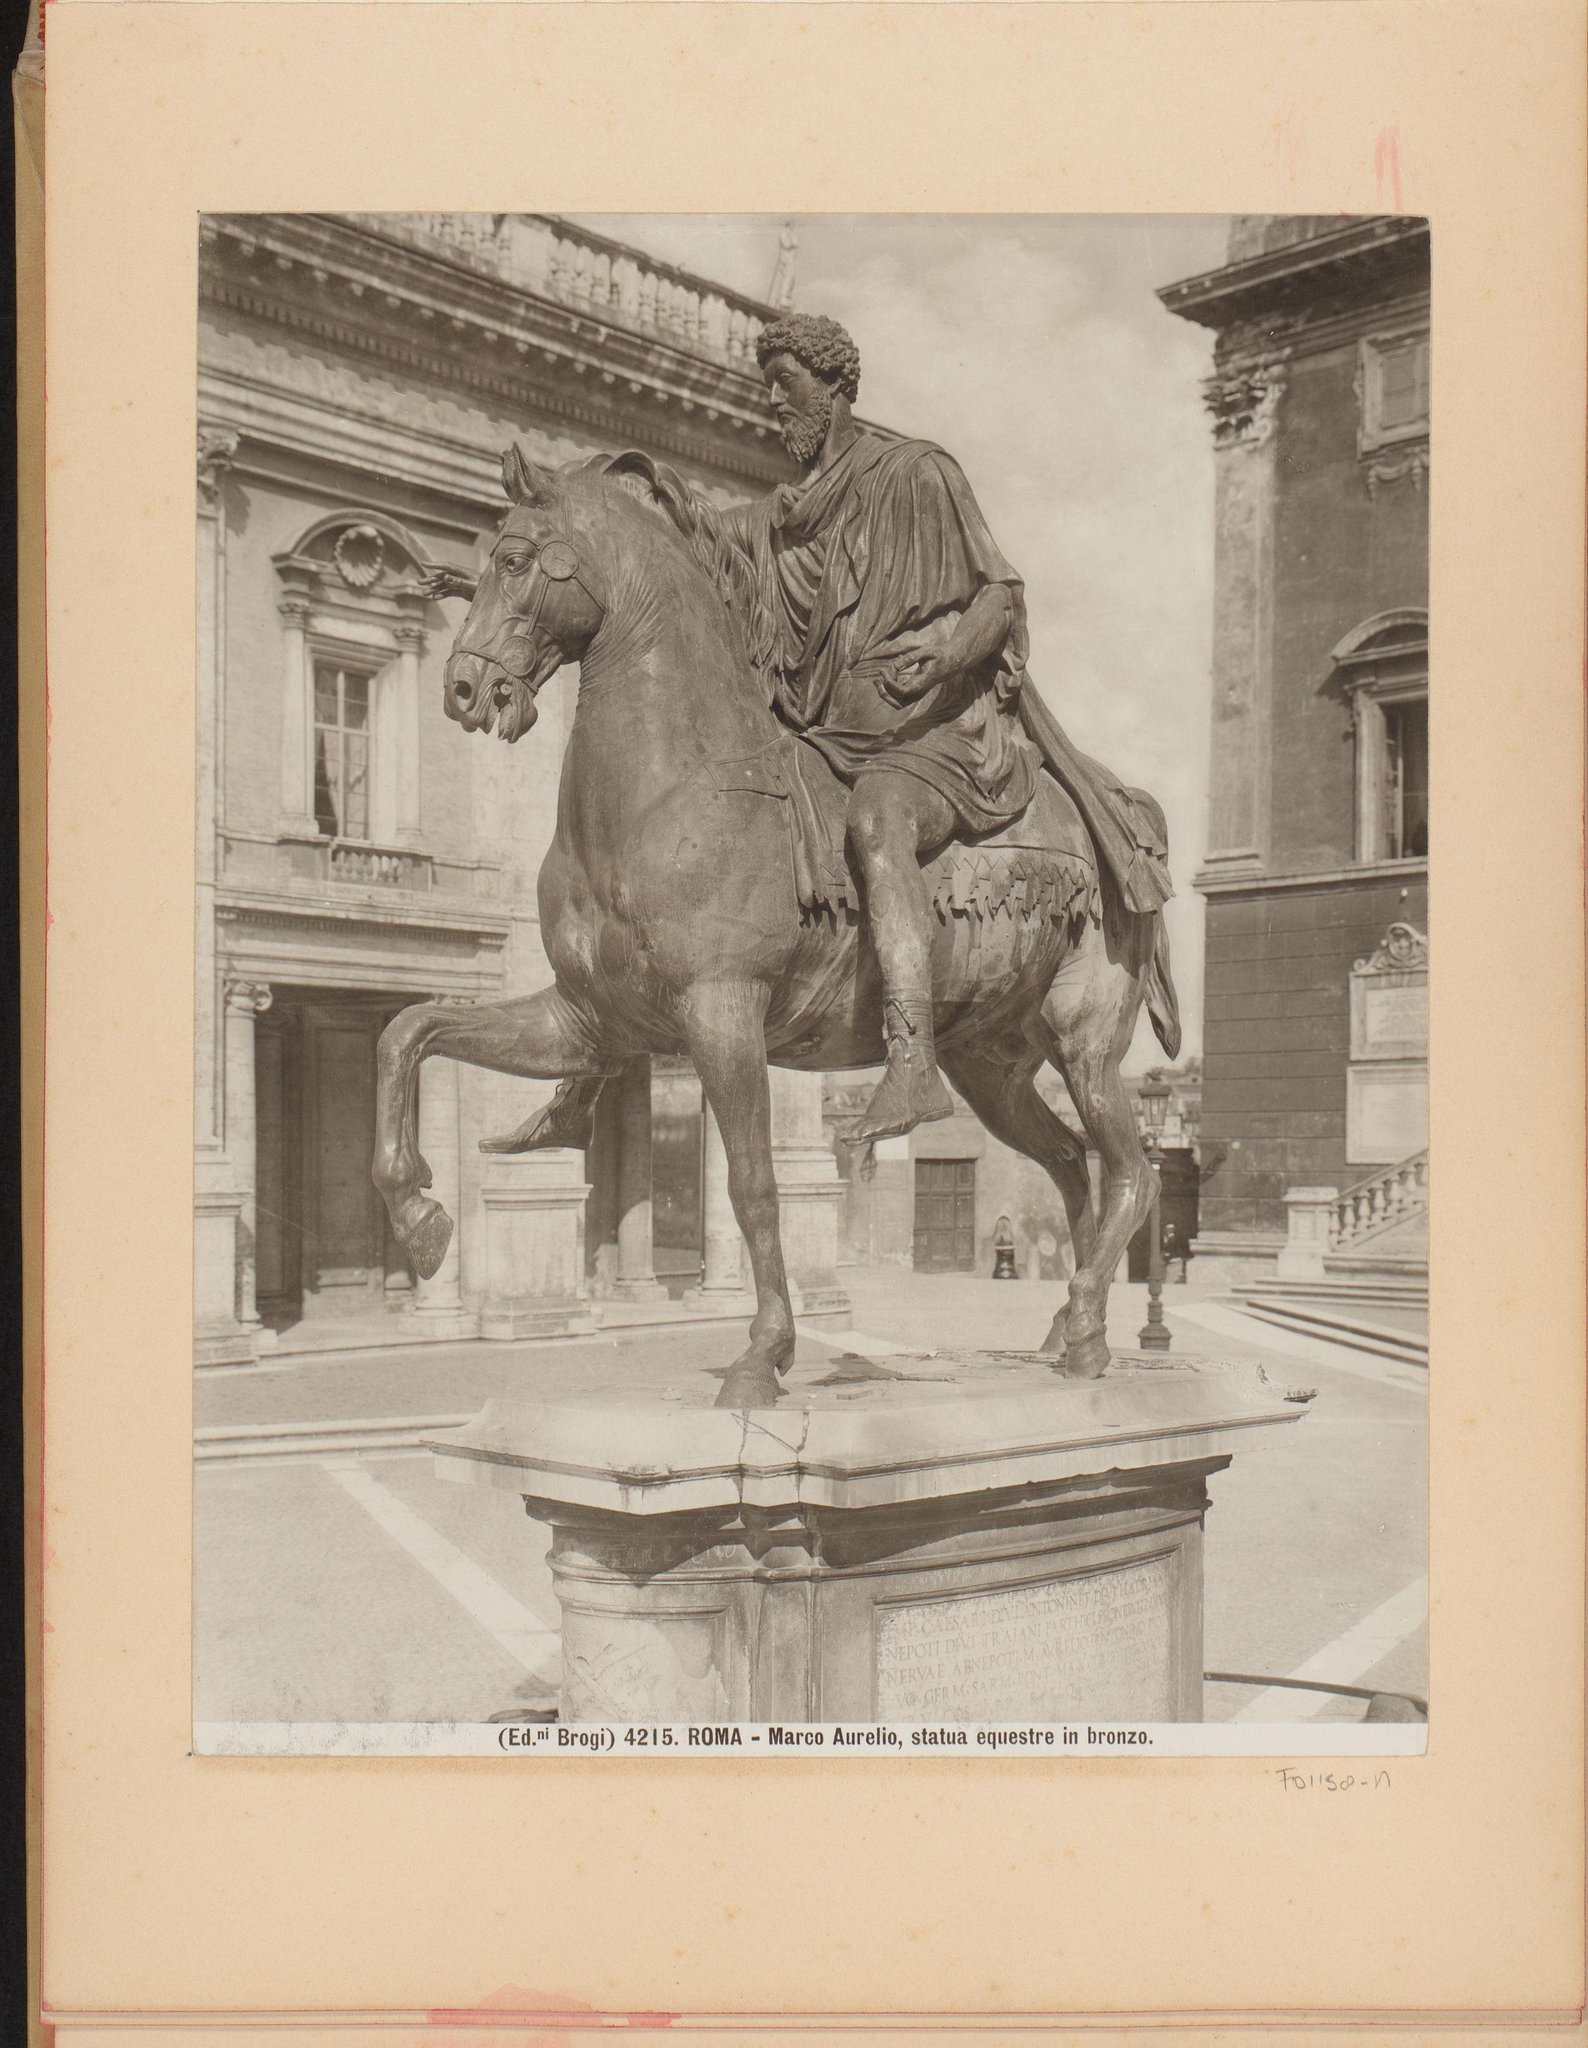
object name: photograph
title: Roma - Marco Aurelio, statua equestre in bronzo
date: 1875-1907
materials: photographic support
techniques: gelatin silver print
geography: piazza del campidoglio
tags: equestrian statue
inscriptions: number: ‘4215’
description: Onderdeel van Fotoalbum met opnames van bezienswaardigheden en kunstwerken in Italië.